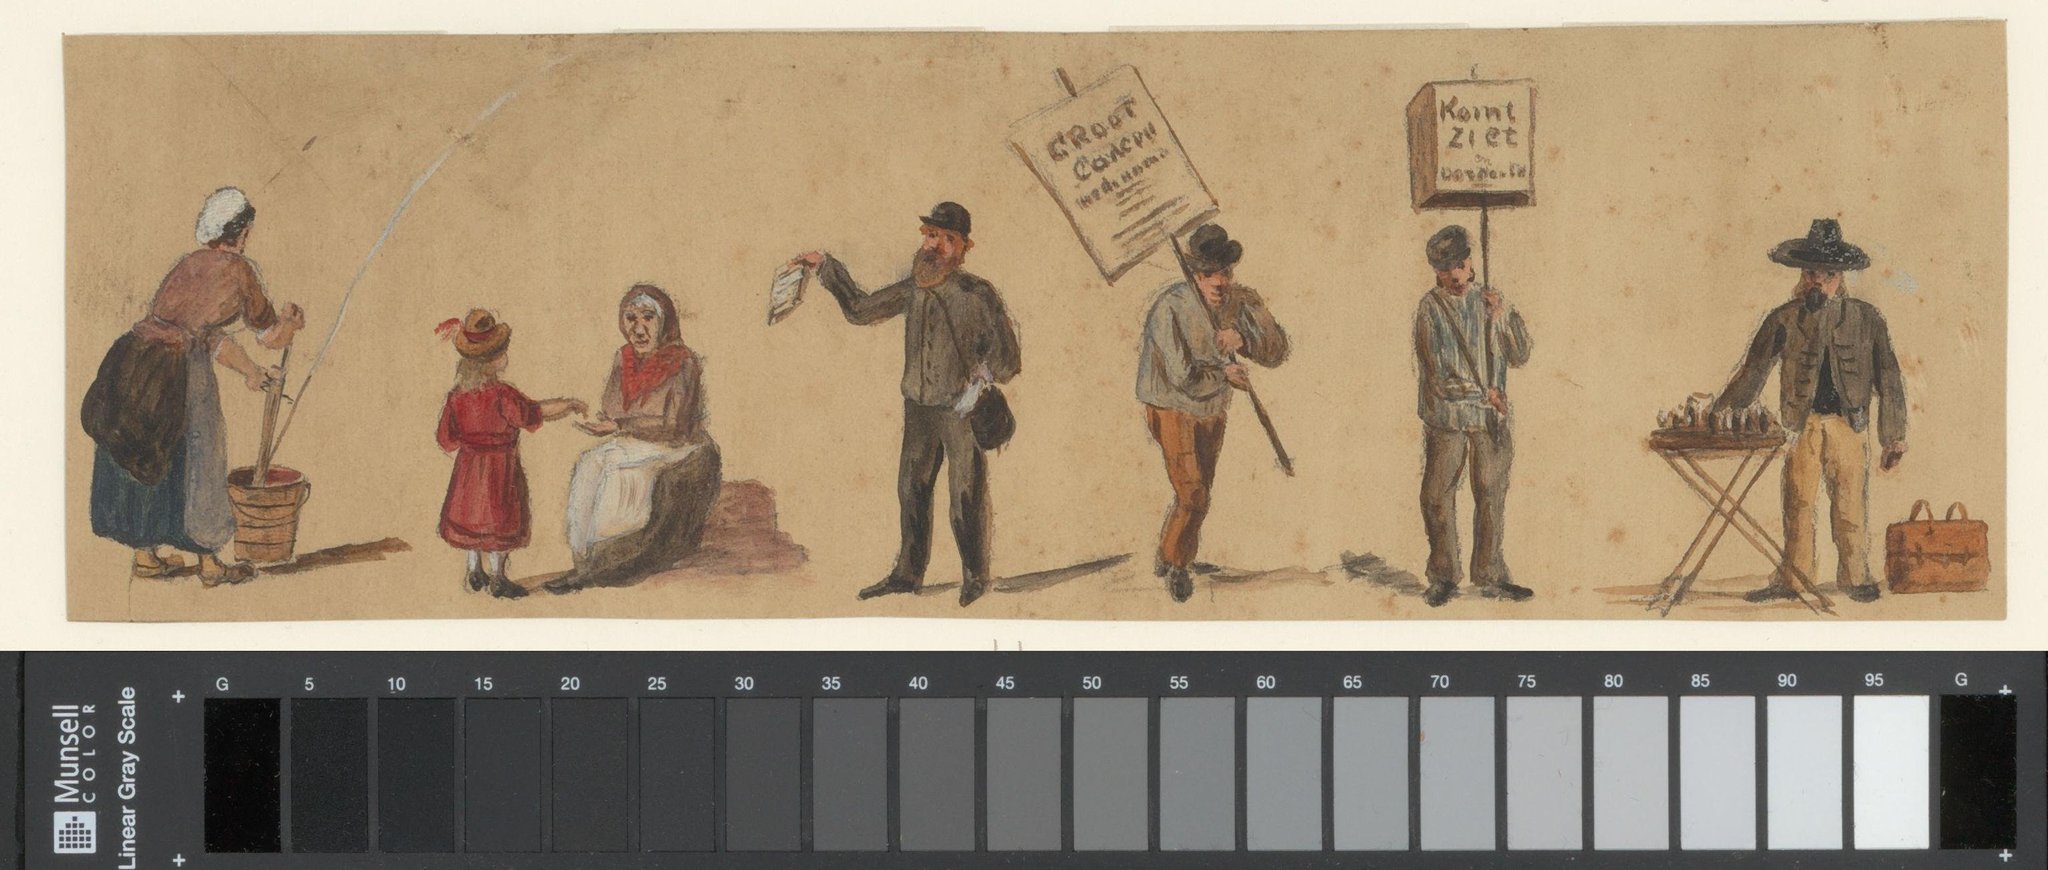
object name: drawing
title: Zeven figuren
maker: pierre jean fardon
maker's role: amateurschilder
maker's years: 1838-1911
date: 1850-1911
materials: chalk, paper, watercolor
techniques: brush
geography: netherlands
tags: window-cleaning, sandwich-man, street-trader, maid ~ house personnel, beggar, amsterdam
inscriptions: collector's mark, collector's mark: Lugt 1641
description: Zeven figuren: een dienstbode met een ramenspuit, een meisje dat een bedelares een aalmoes geeft, een venter met kranten of pamfletten, een man met een reclamebord waarop een 'groot concert' wordt aangekondigd, een tweede man met een reclamebord waarop staat 'komt ziet' en een man naast een tafeltje met koopwaar. Onderdeel van een serie van 16 bladen met tekeningen van Amsterdamse volkstypen. Onderwerpsrubrieken binnen de Atlas Zeden en Gewoonten: Mannelijk beroep en bedrijf: Marskramers, straatventers, straatslijpers, bedelaars, straatvertooningen enz.